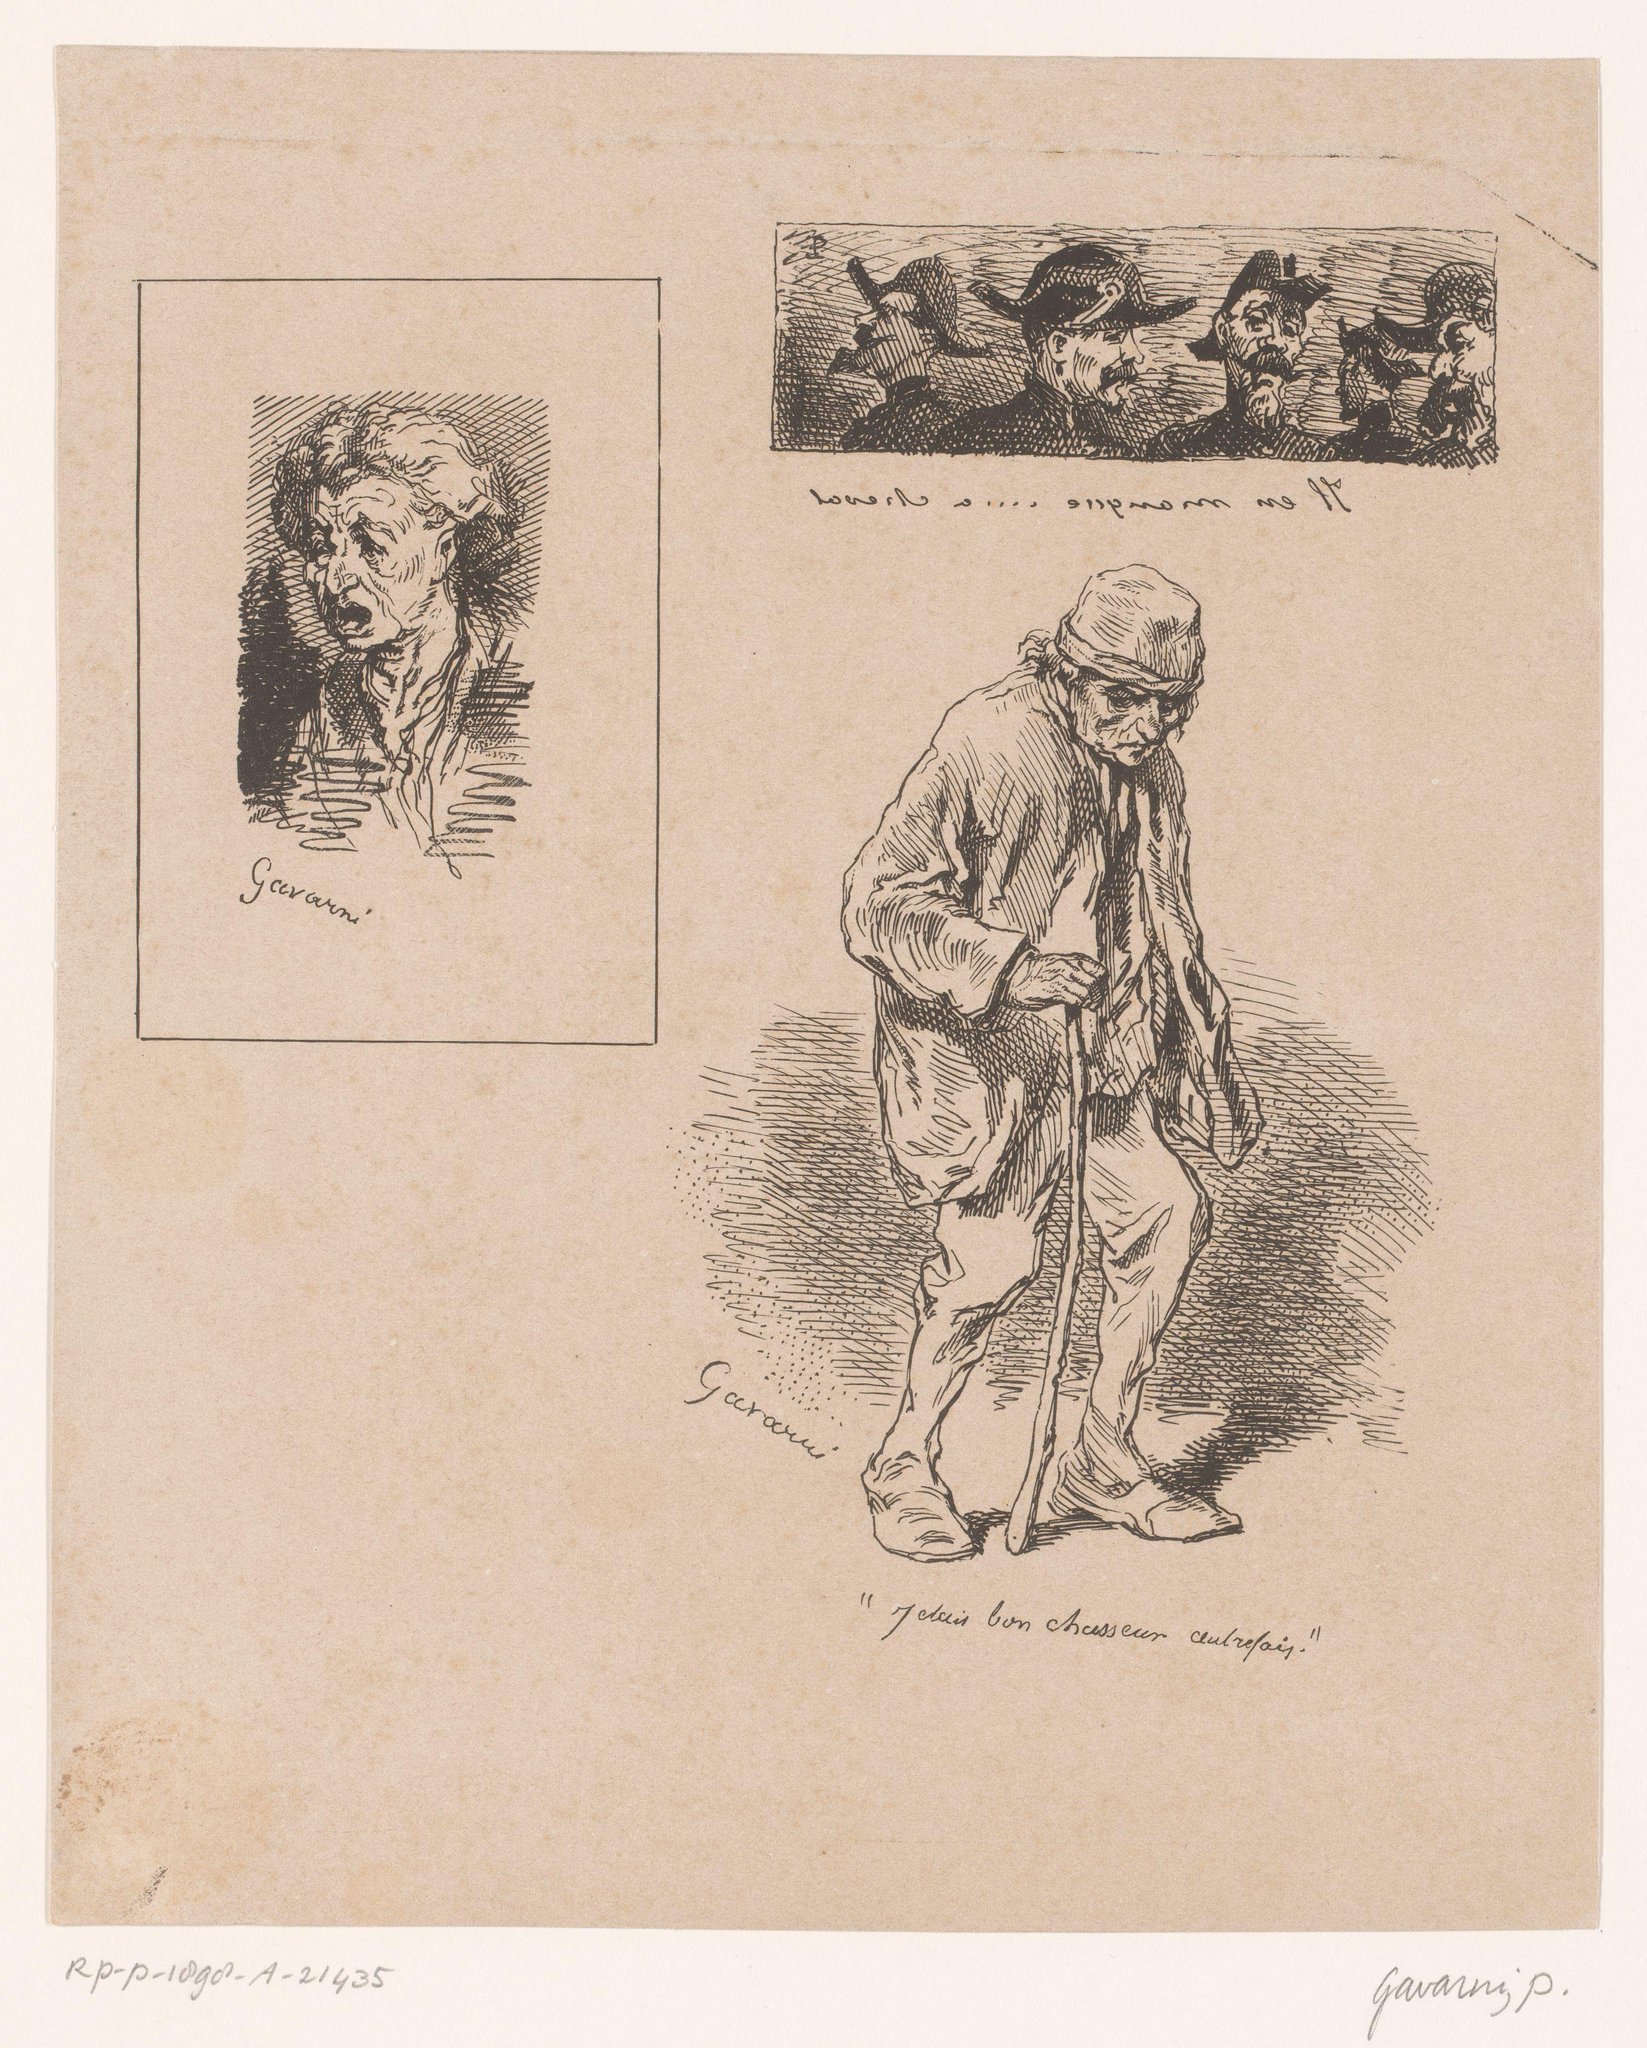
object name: print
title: J'étais bon chasseur autrefois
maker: paul gavarni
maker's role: draughtsman, print maker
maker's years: 1804-1866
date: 1856-1859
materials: paper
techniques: etching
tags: old man, the soldier; the soldier's life, the poor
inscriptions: collector's mark: Lugt 964, annotation: ‘Il en manque... à cheval’